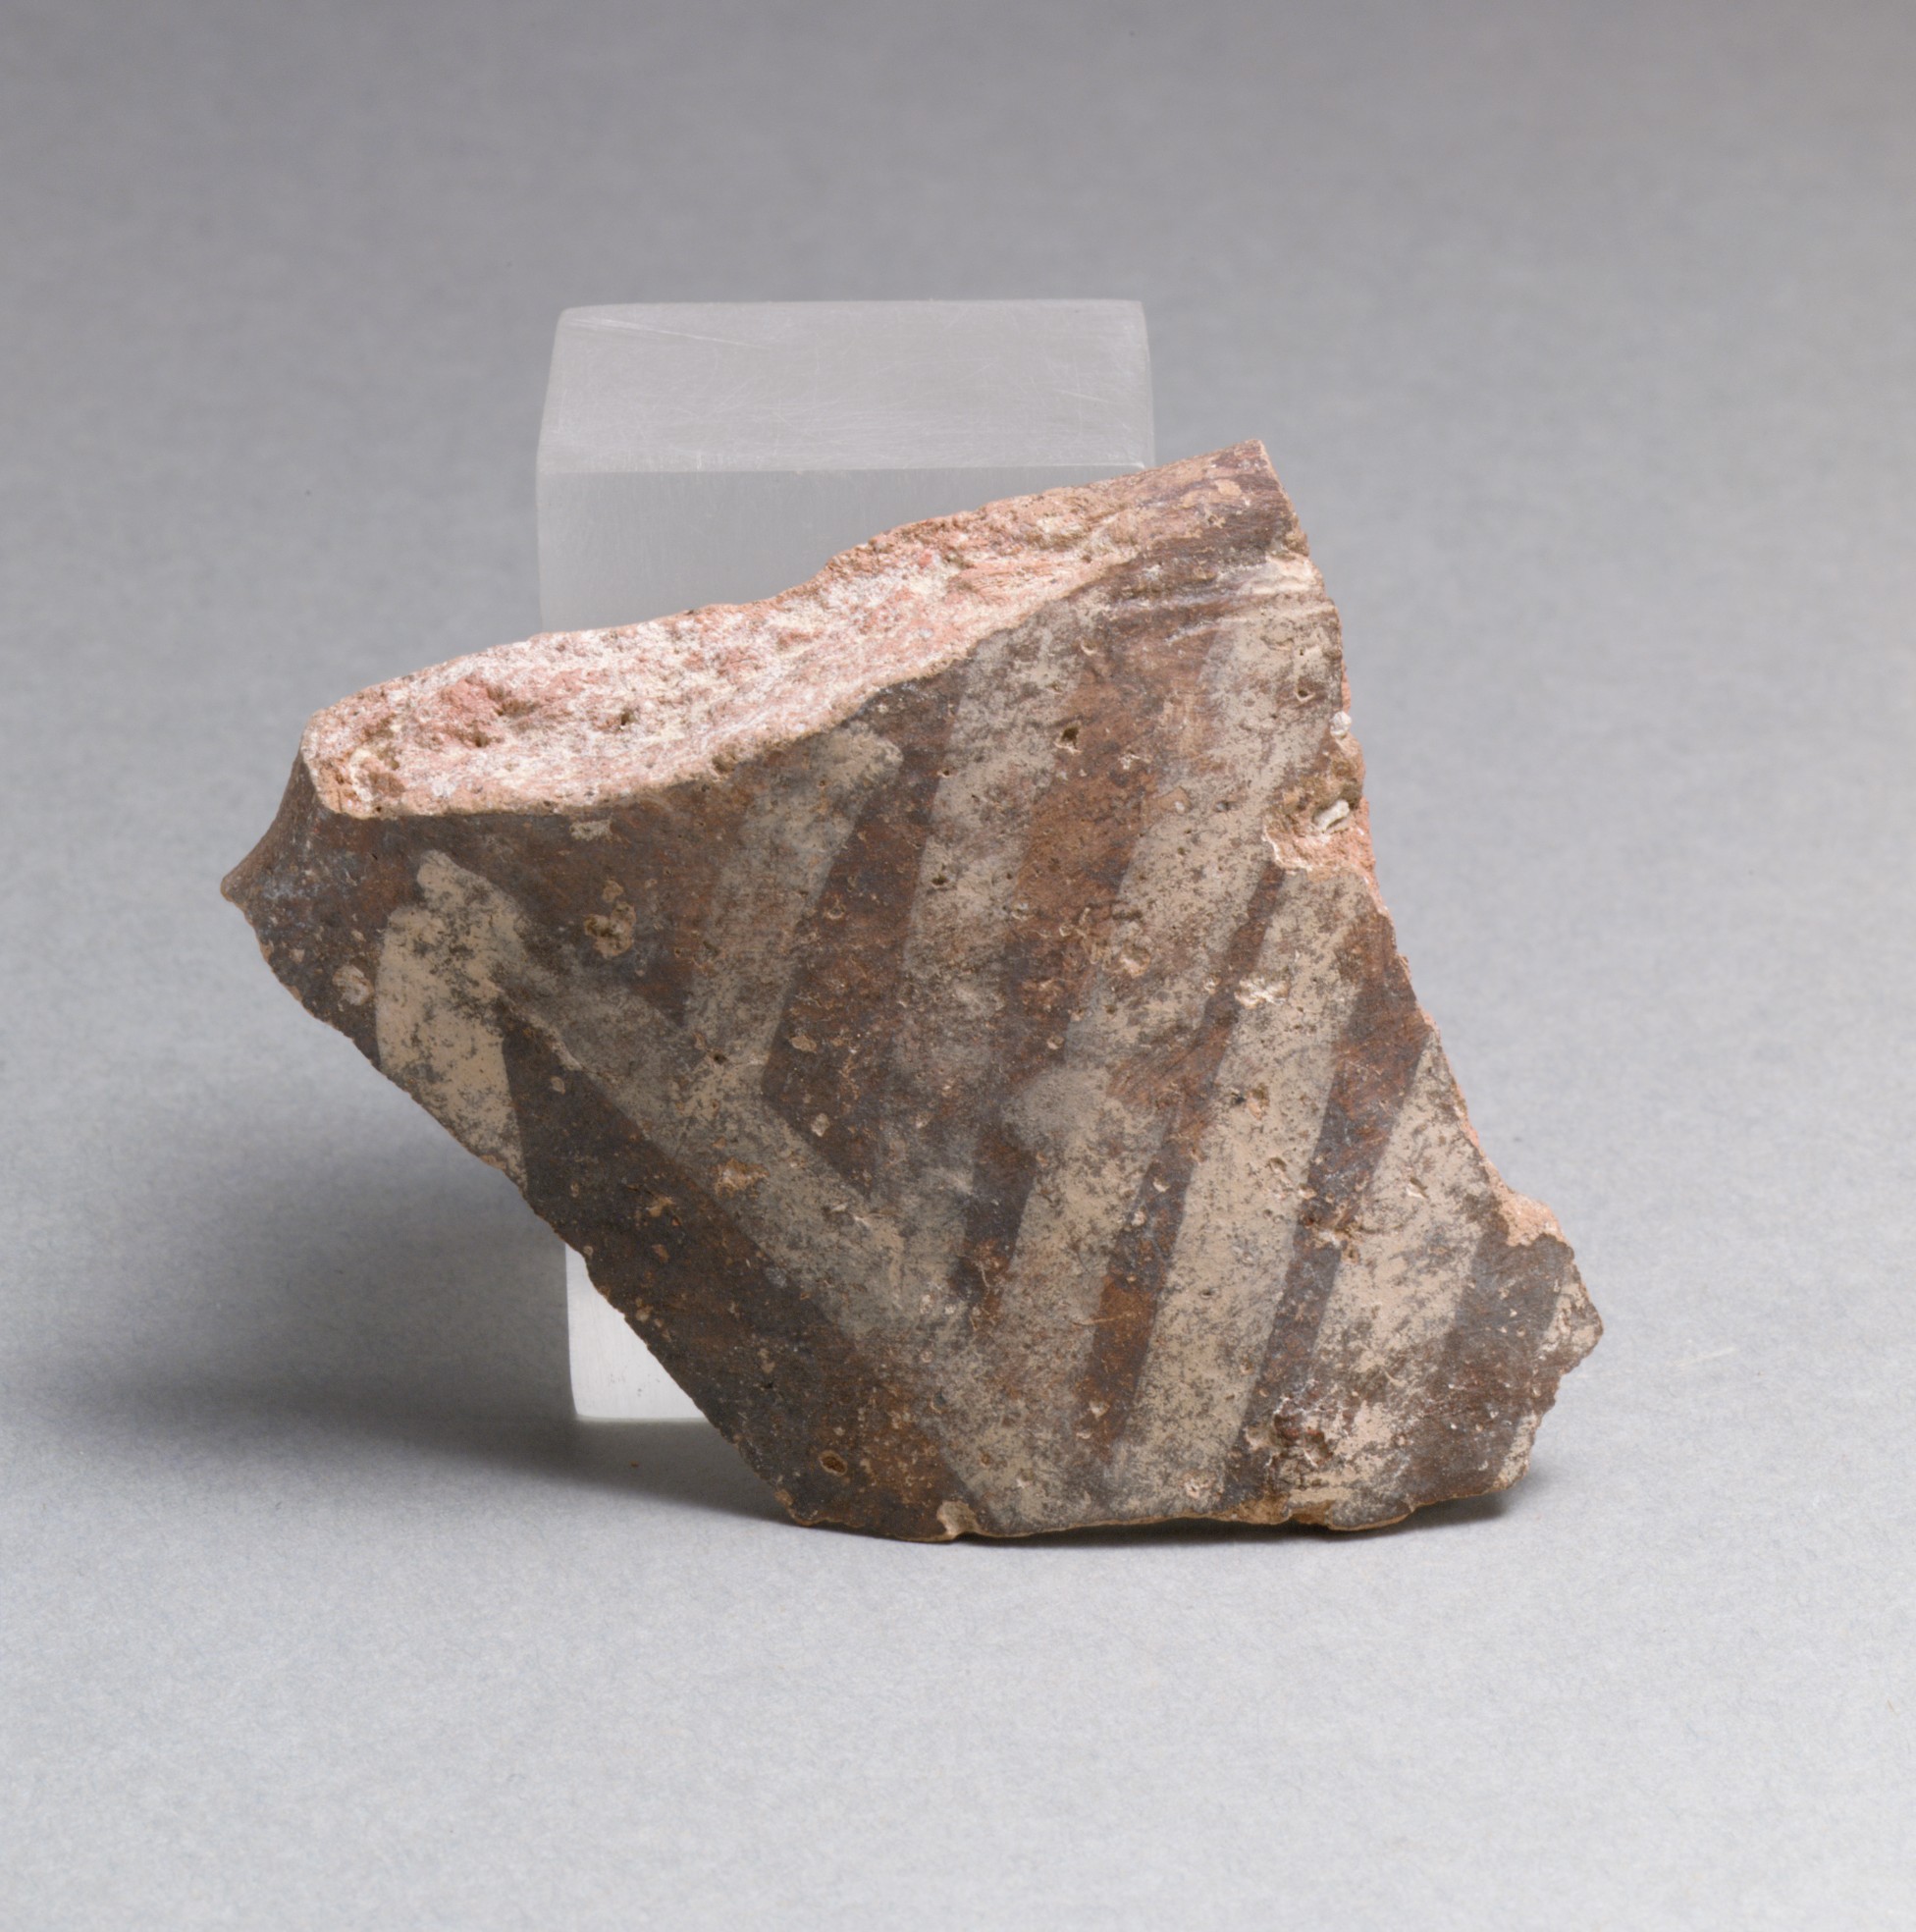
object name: vase fragment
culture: minoan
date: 2600-2000 BCE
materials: terracotta